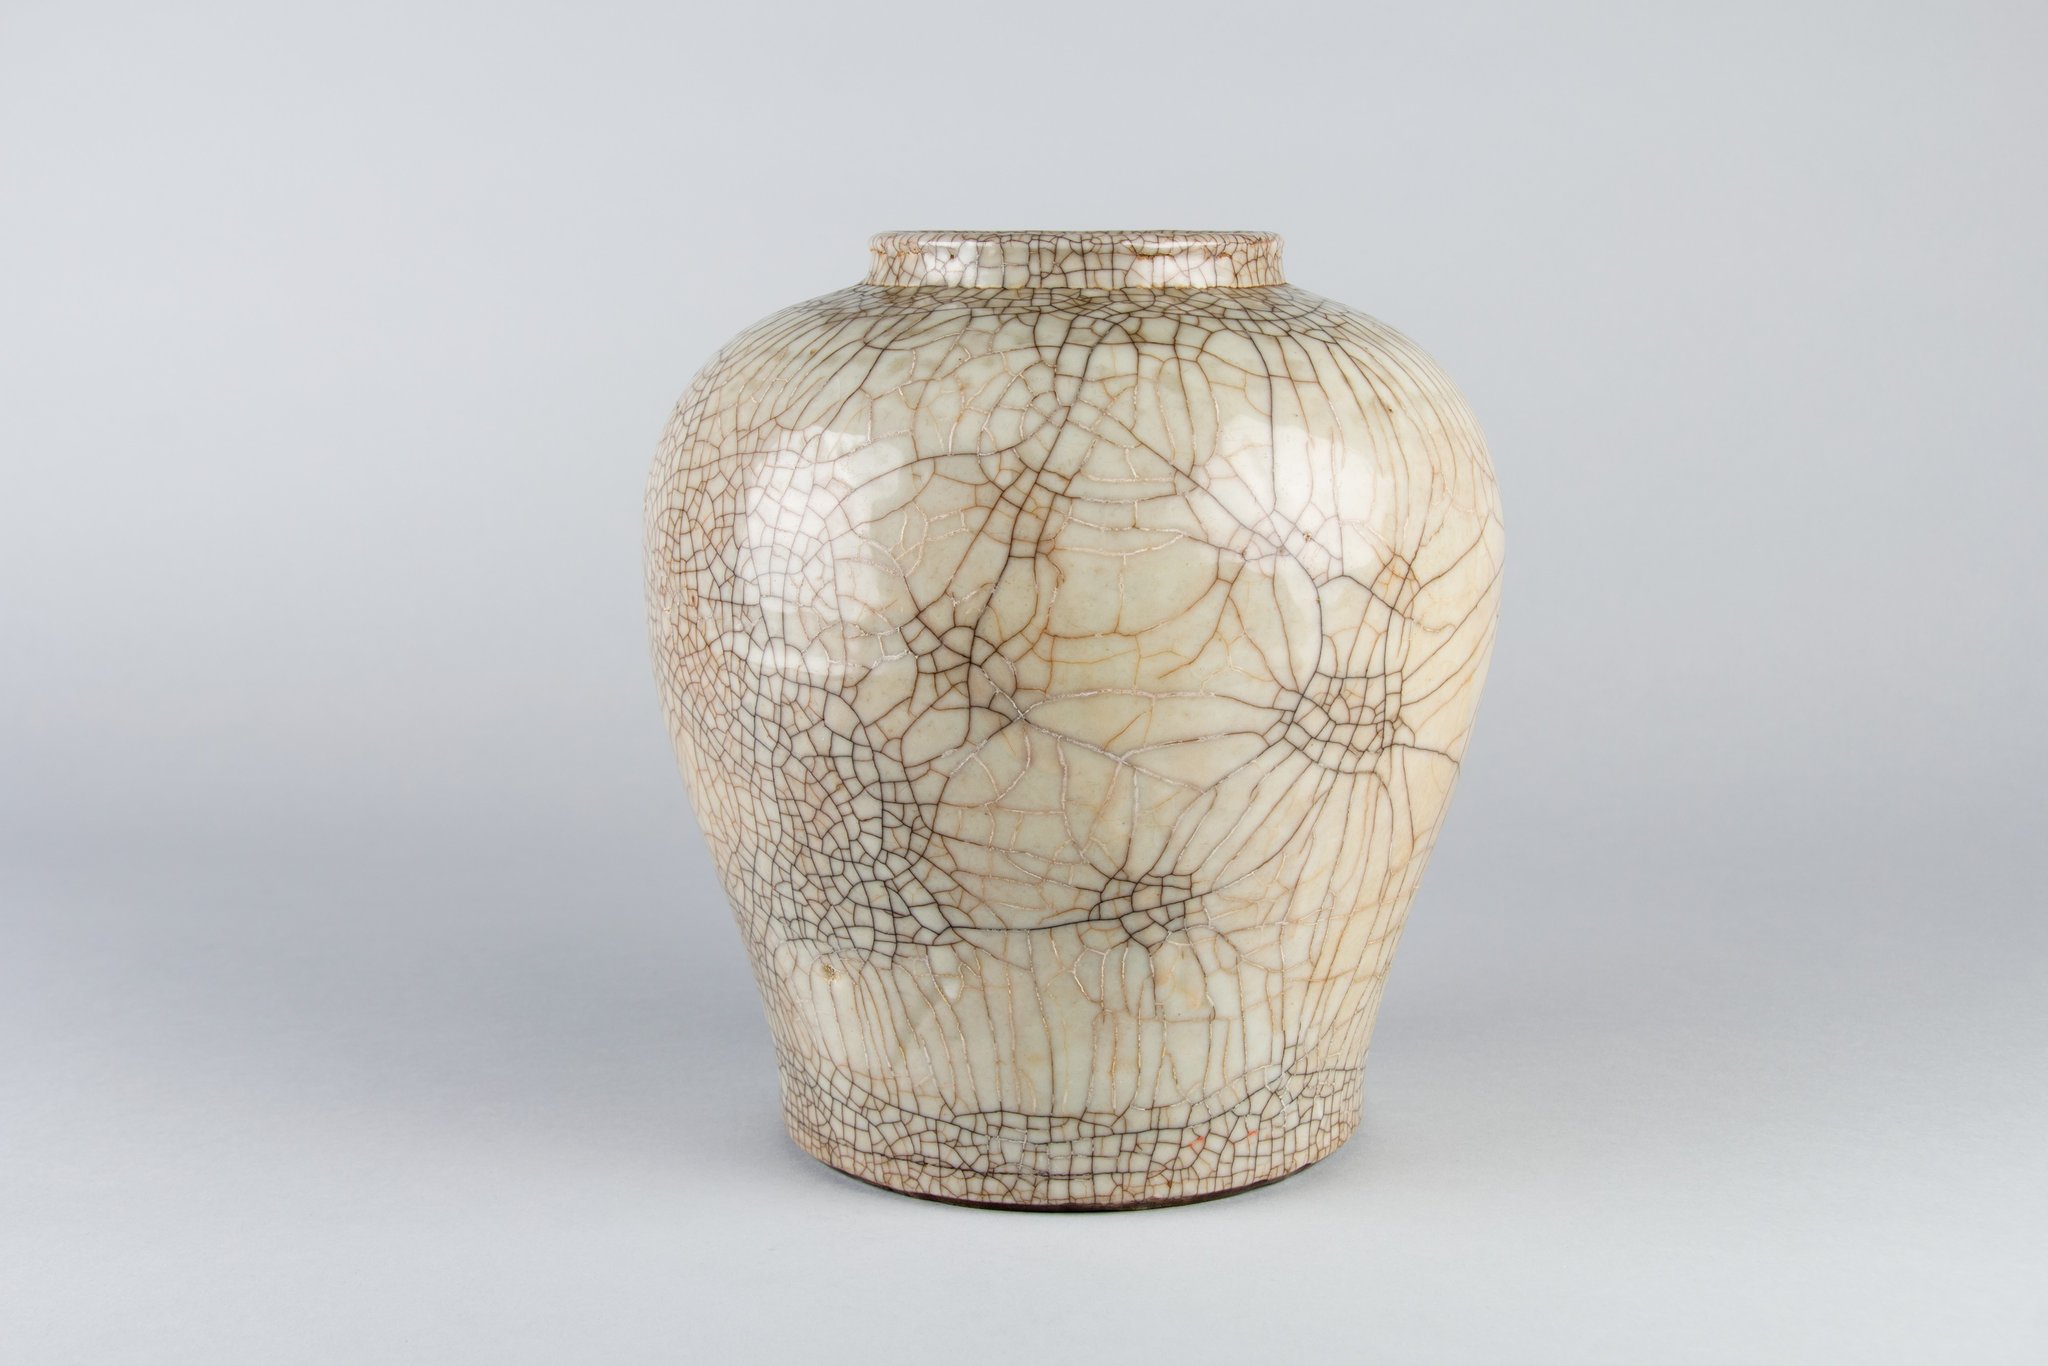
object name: jar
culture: chinese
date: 1501-1600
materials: glaze, porcelain